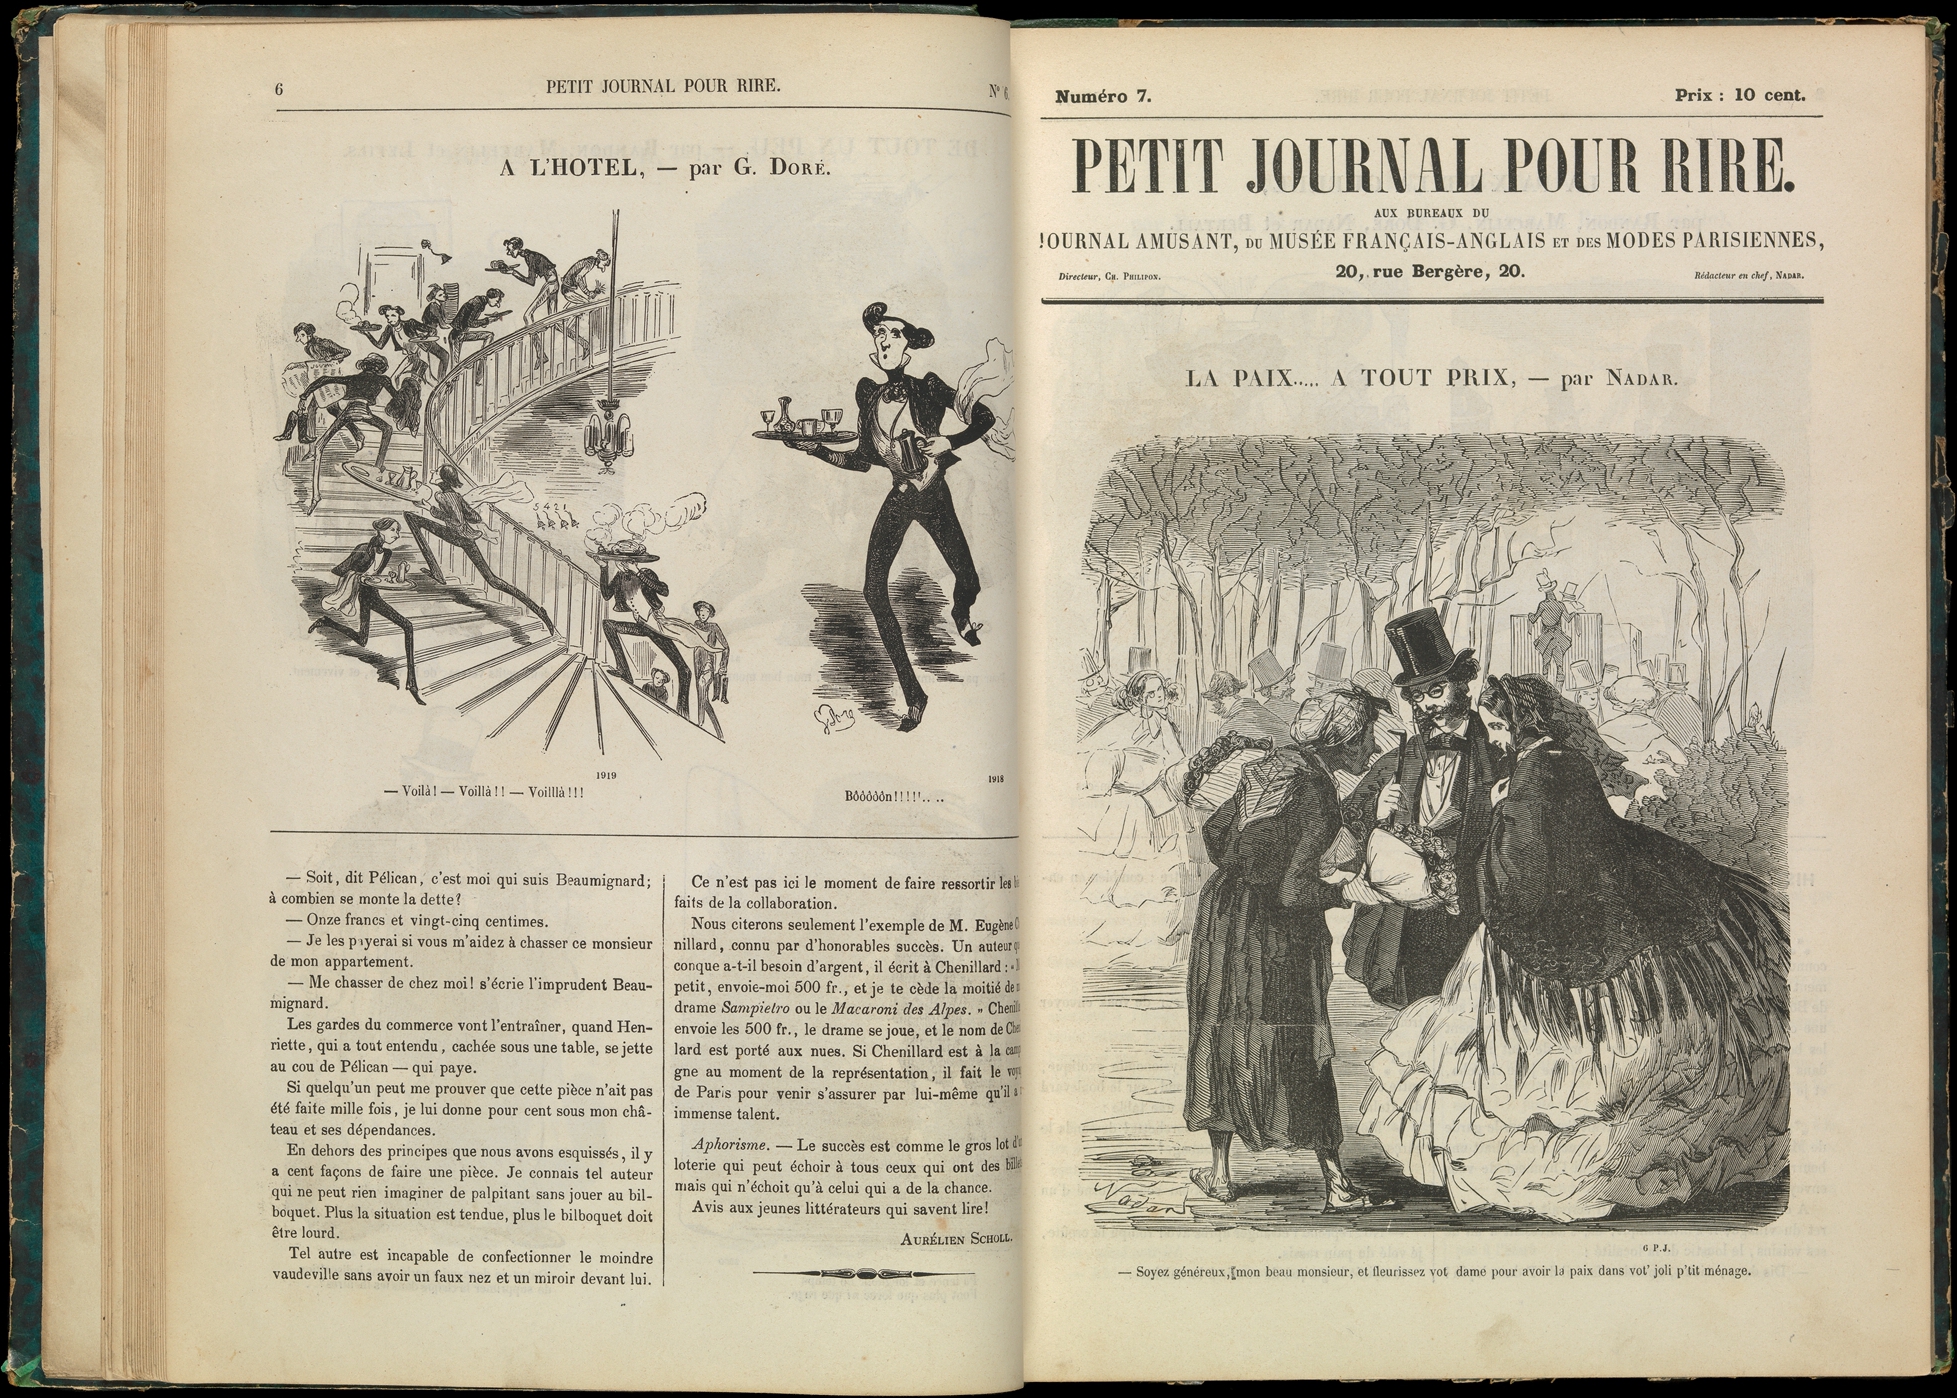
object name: book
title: Petit Journal pour Rire vol. 1, (nos. 1-52)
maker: charles philipon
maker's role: editor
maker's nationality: french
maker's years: 1800-1862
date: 1856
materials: wood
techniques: engraving, letterpress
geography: france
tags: men,women